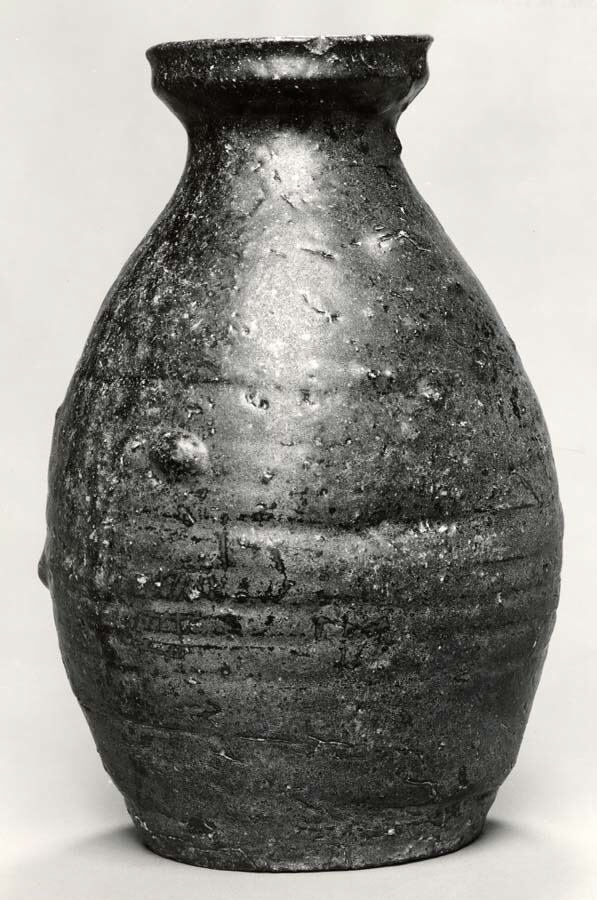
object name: bottle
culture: korean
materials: glaze, stoneware